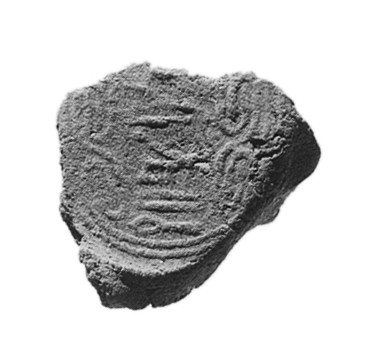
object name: sealing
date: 2030-1640 BCE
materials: clay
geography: egypt